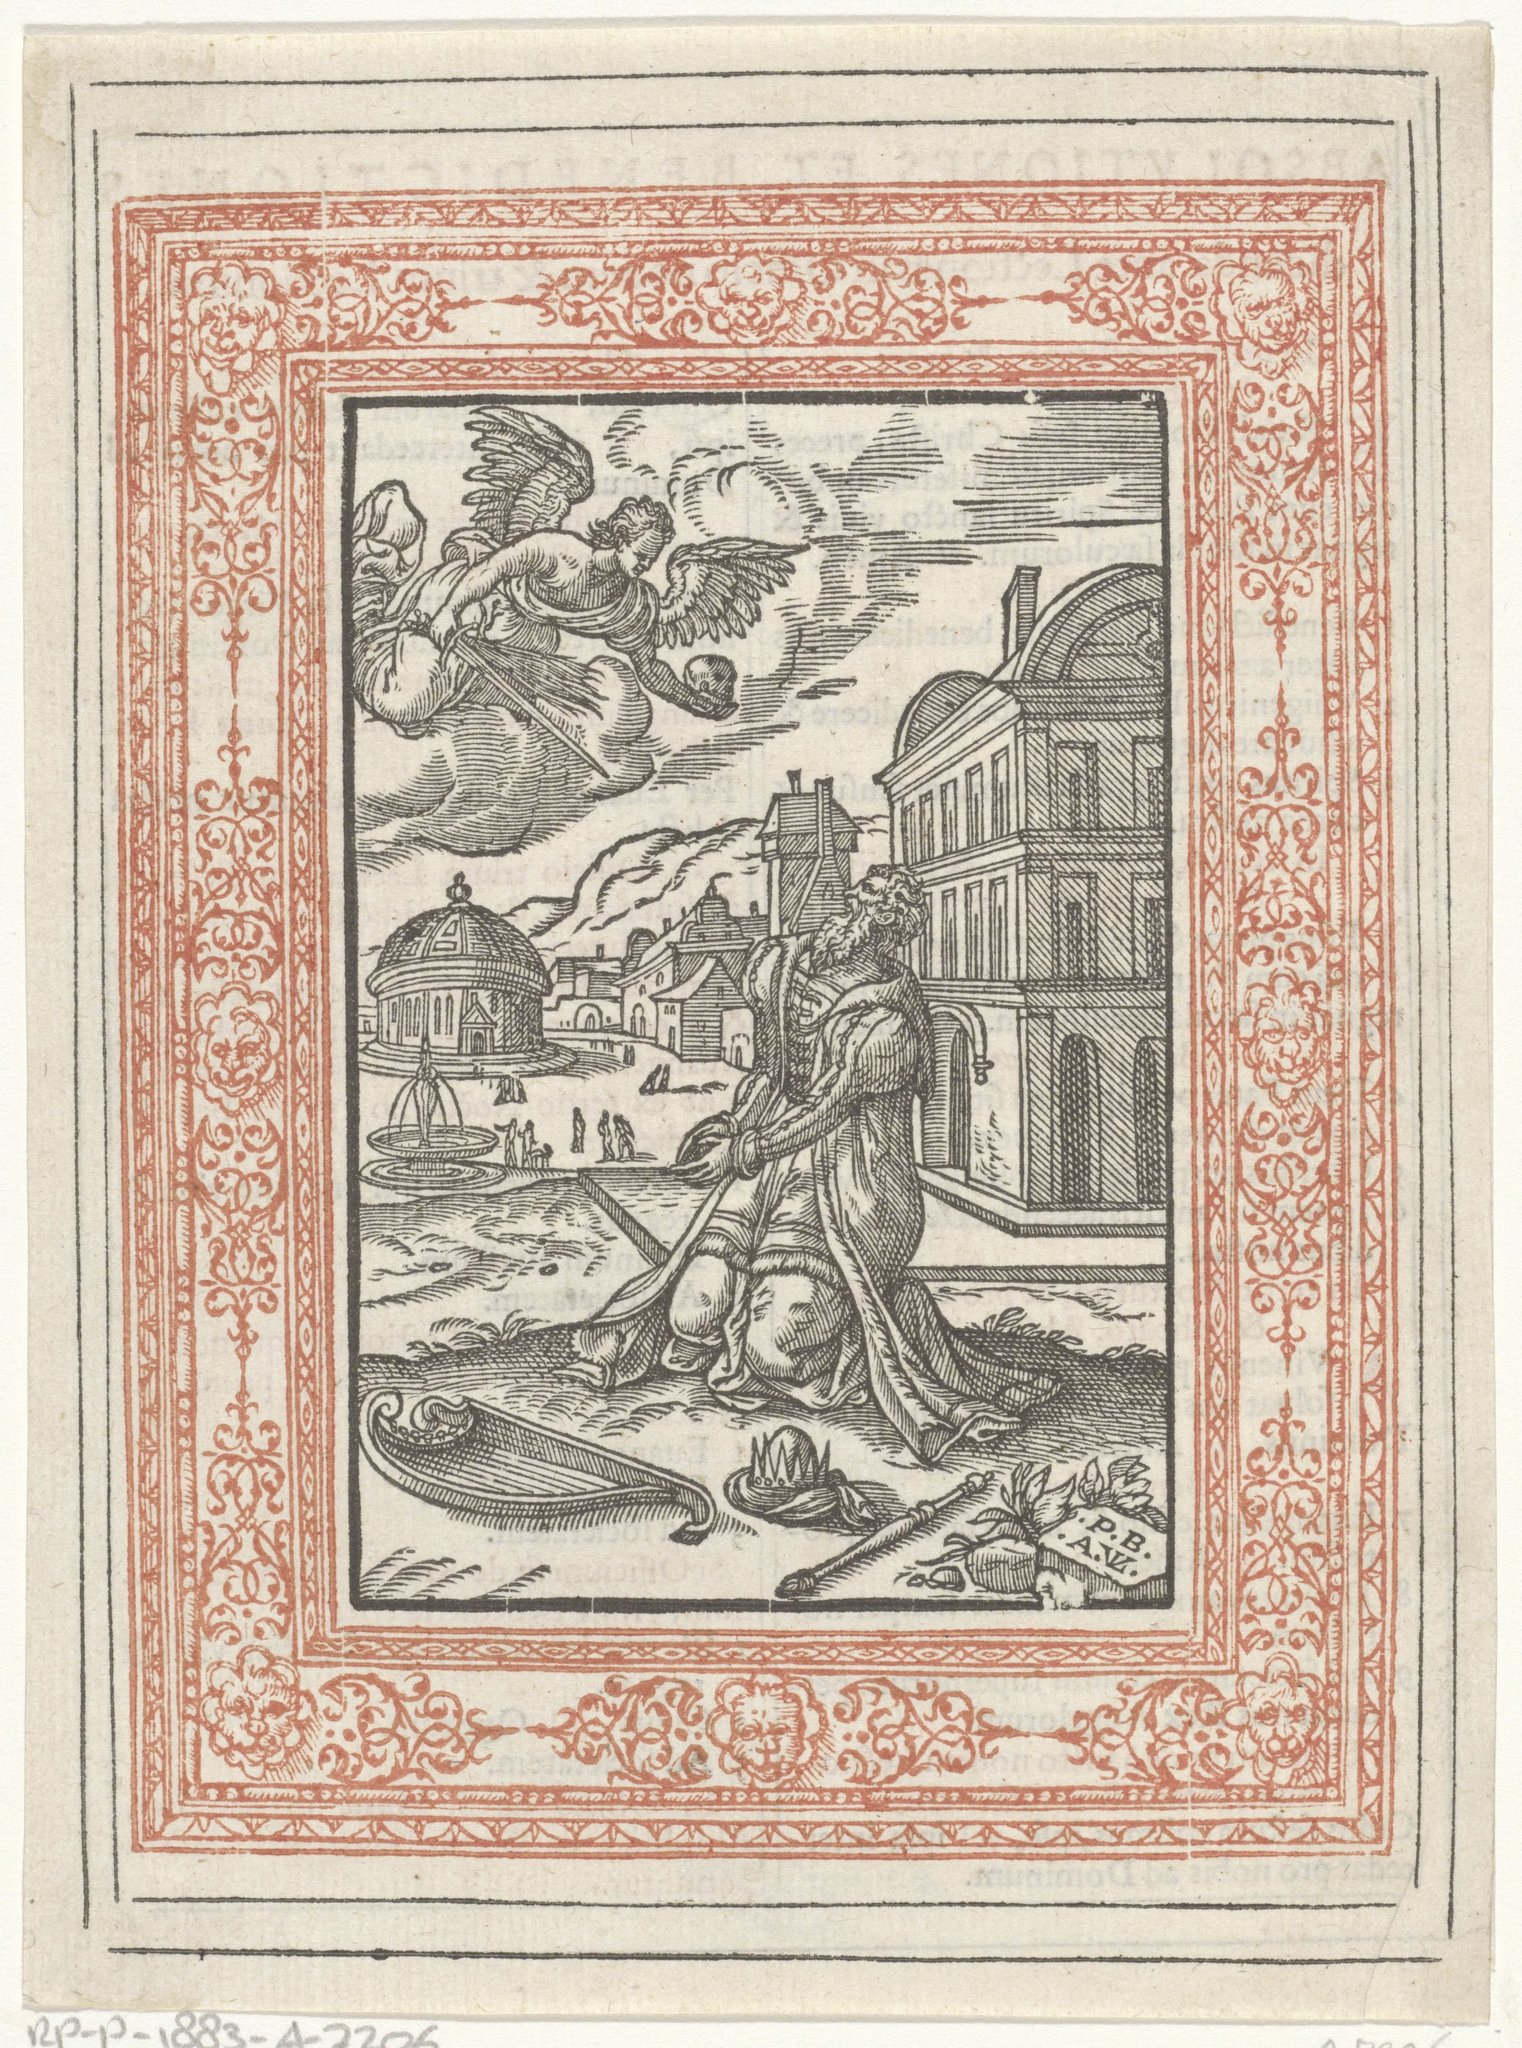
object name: book illustration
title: Knielende David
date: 1571-1632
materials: paper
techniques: letterpress printing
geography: antwerp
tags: david sacrificing (in general)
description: Een engel toont David een doodshoofd, een zwaard en een roede. Geheel in een geornamenteerde omlijsting.